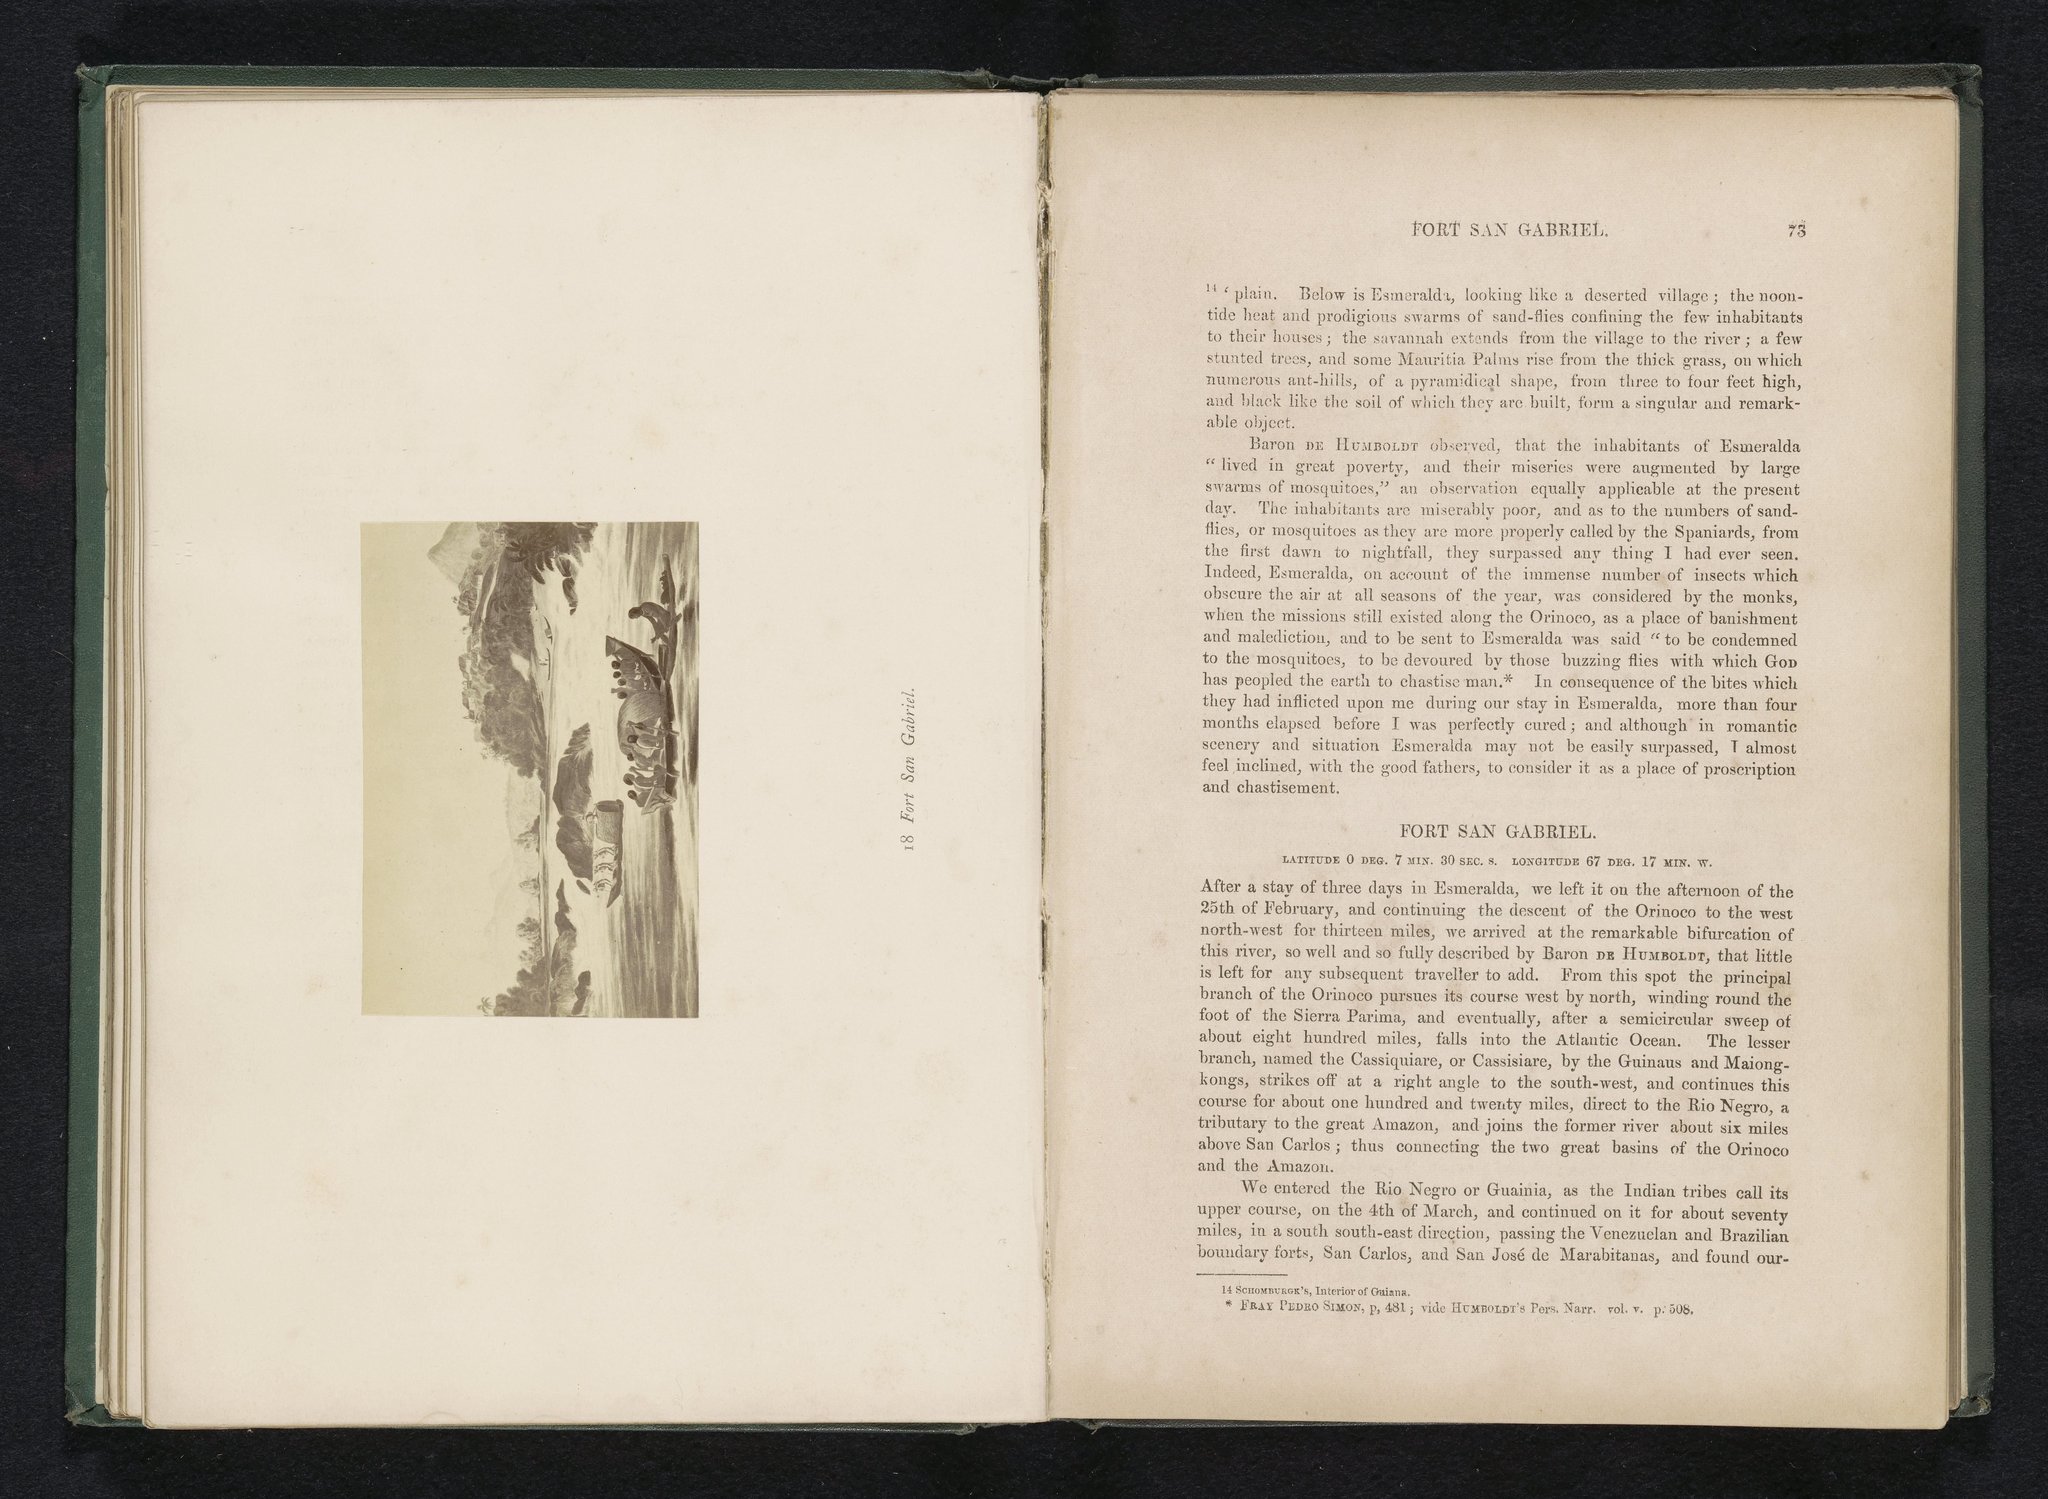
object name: photograph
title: Fotoreproductie van een tekening van het fort San Gabriel aan de Rio Negro met boten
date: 1856-1866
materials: photographic support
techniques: albumen print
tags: castle, river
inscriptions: number: ‘18’